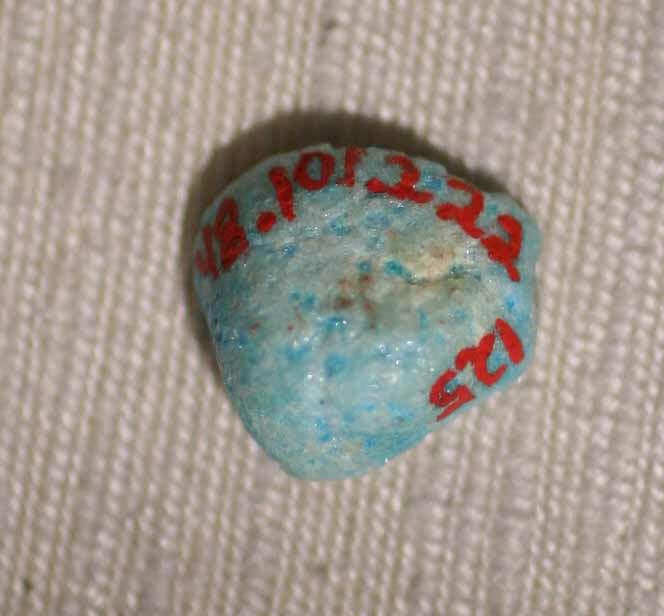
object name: bead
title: Beads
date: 701-1300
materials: earthenware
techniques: glazing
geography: iran